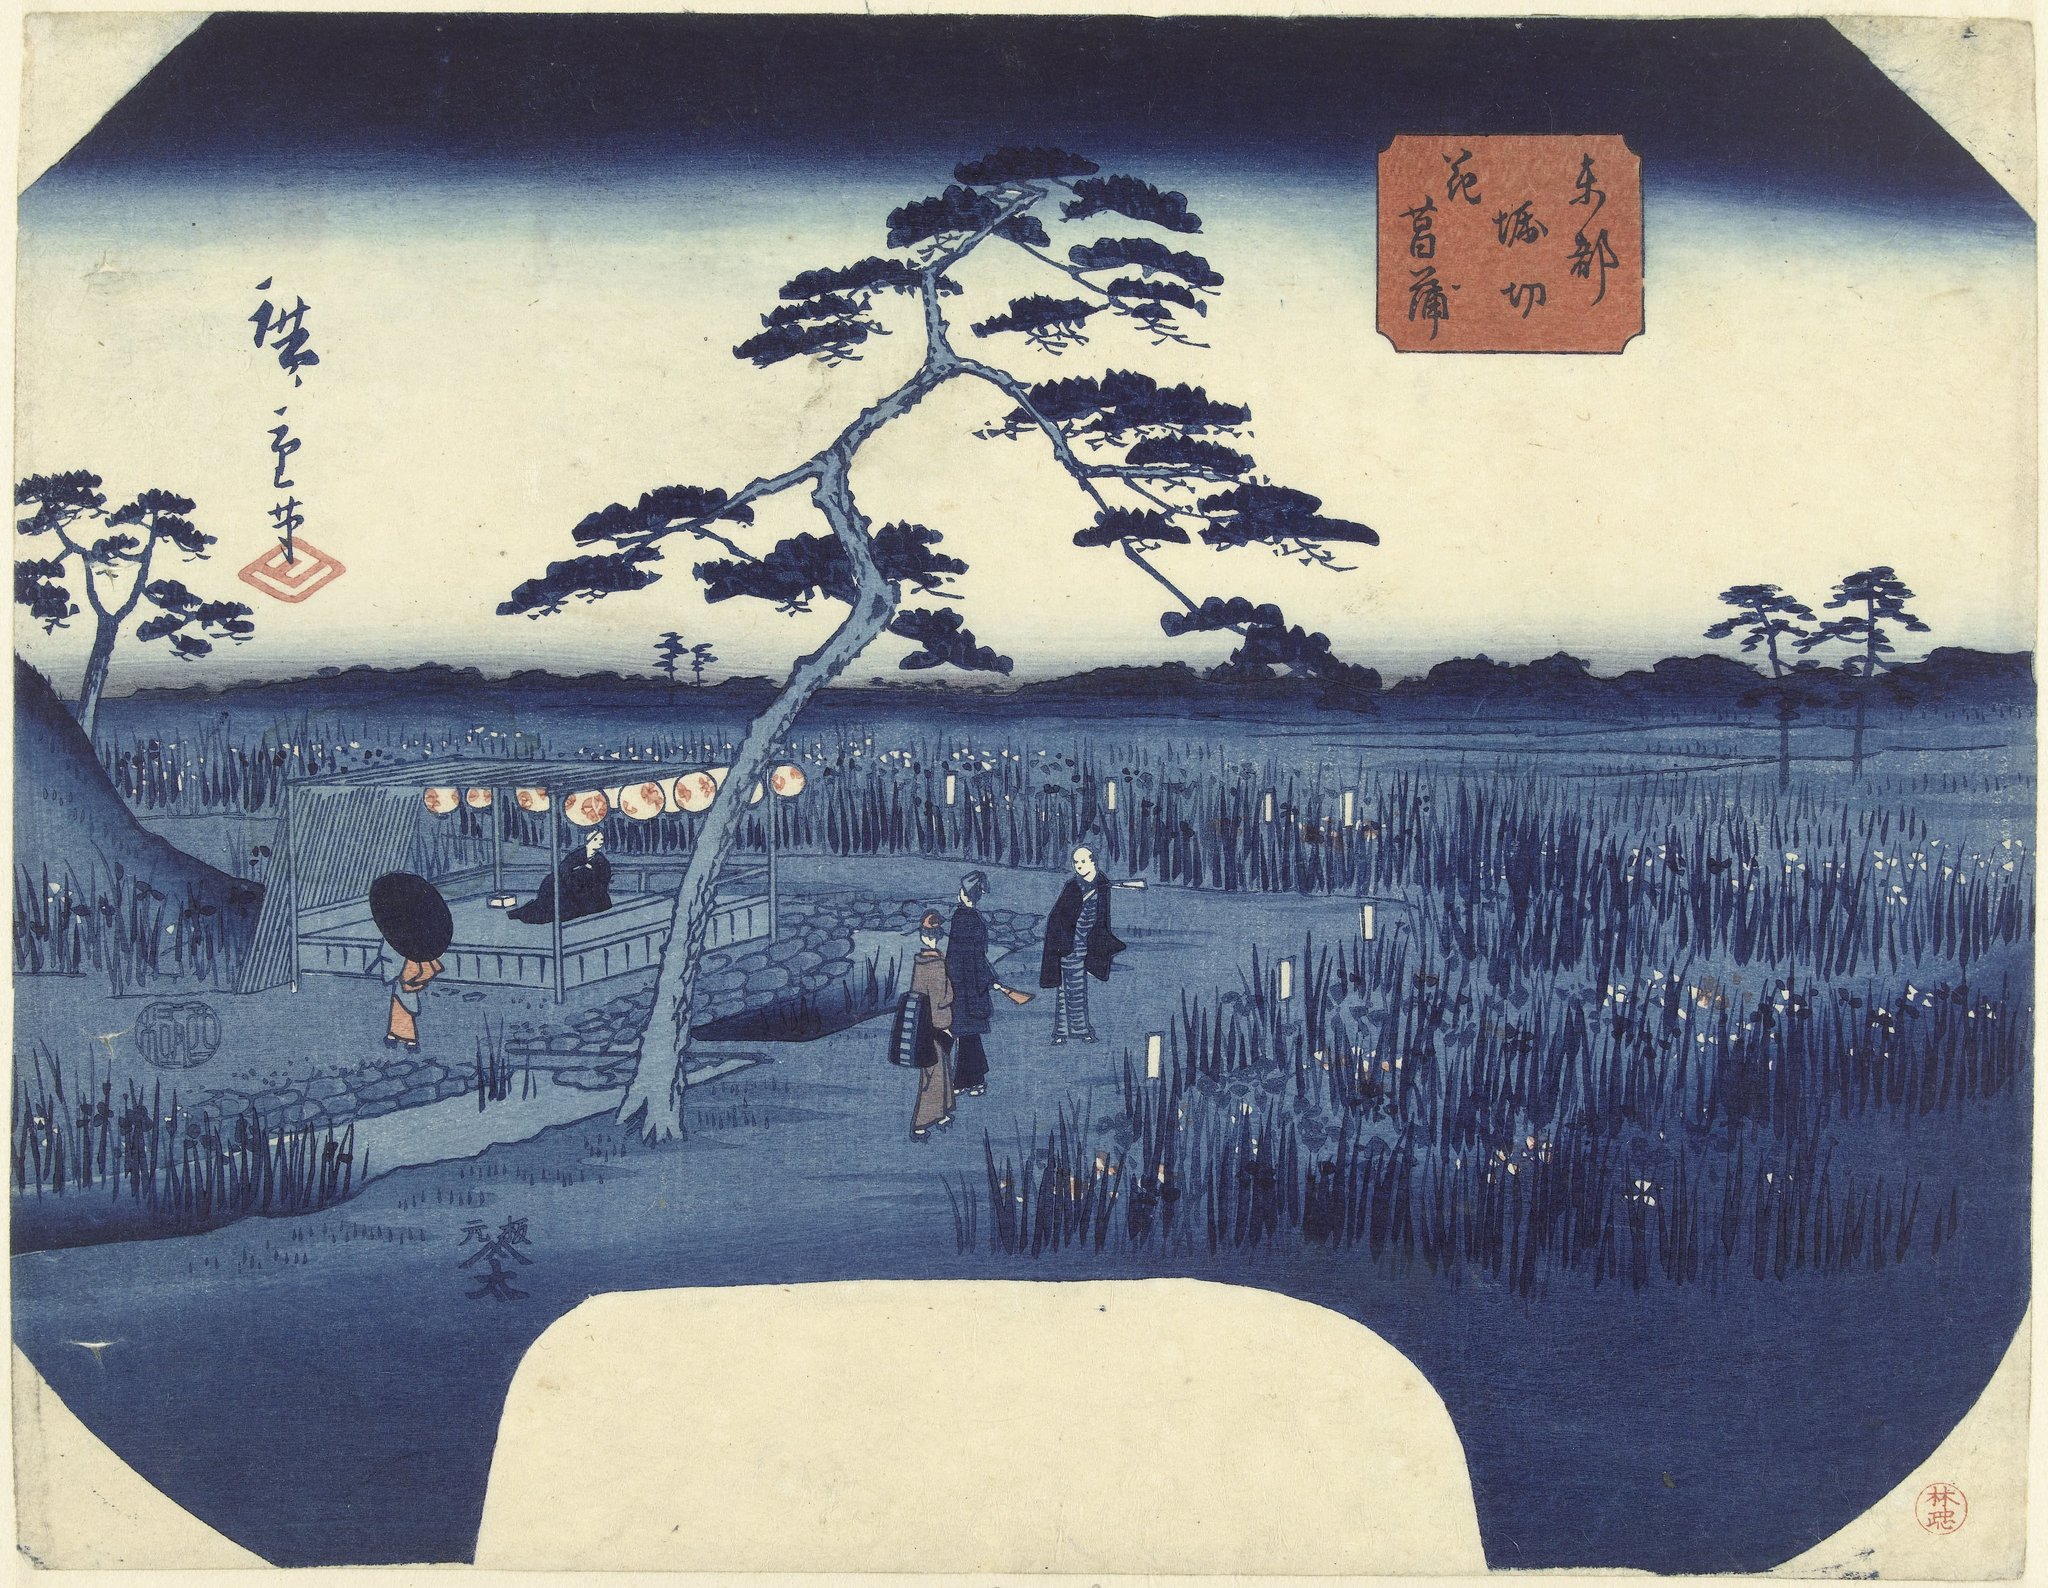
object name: uchiwa e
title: Bloeiende irissen te Horikiri in de Oostelijke hoofdstad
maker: utagawa hiroshige (ii)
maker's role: print maker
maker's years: 1826-1869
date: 1861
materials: paper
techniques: woodcut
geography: japan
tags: flowers, landscapes (+ landscape with figures, staffage)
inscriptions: collector's mark: Lugt 2971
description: Waaierprent met afbeelding van bezoekers in de beroemde iris tuin bij het Horikiri heiligdom, bij avond.